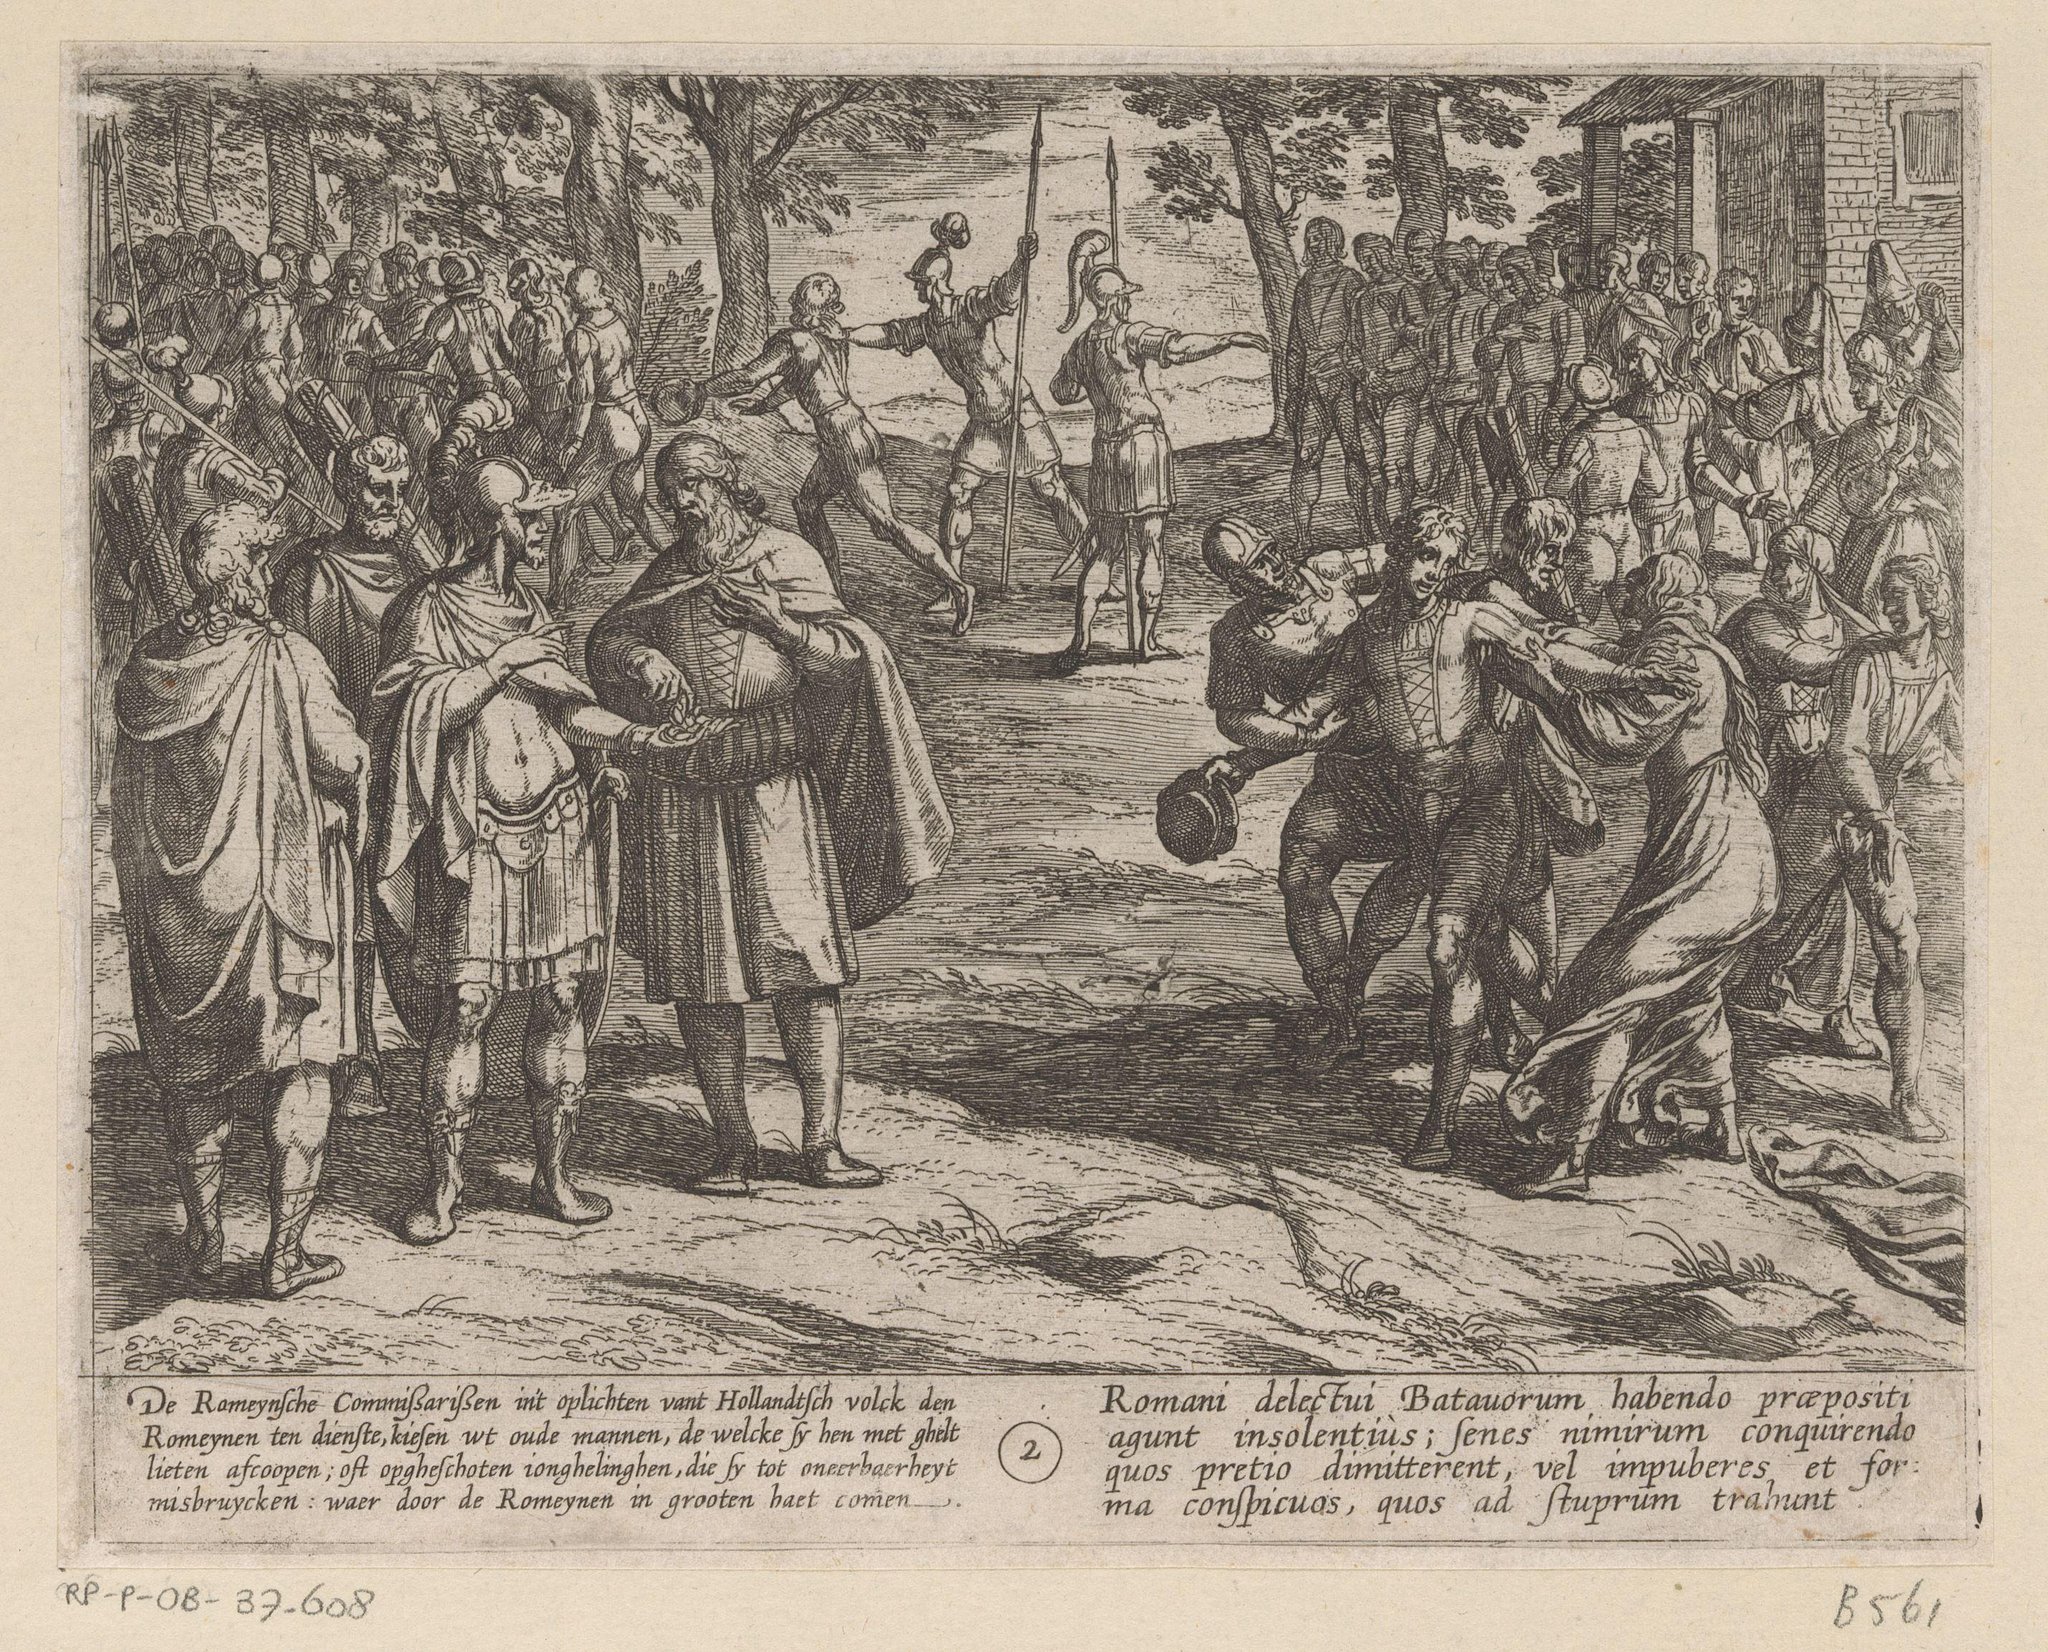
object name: print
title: De Bataafse oorlogen tegen de Romeinen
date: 1611-1612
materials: paper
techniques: etching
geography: southern netherlands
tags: the soldier; the soldier's life, extinct, 'historical' peoples (with name)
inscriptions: collector's mark: Lugt 240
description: Op de voorgrond een oude Nederlandse man die geld ontvangt van een Romeinse generaal. Rechts wordt een jonge Nederlandse man tegen zijn wil vastgehouden door Romeinse soldaten. Zijn moeder probeert de soldaten tegen te houden. Op de achtergrond kiezen Romeinse soldaten Nederlandse mannen uit. Onderschrift in het Nederlands en in het Latijn.